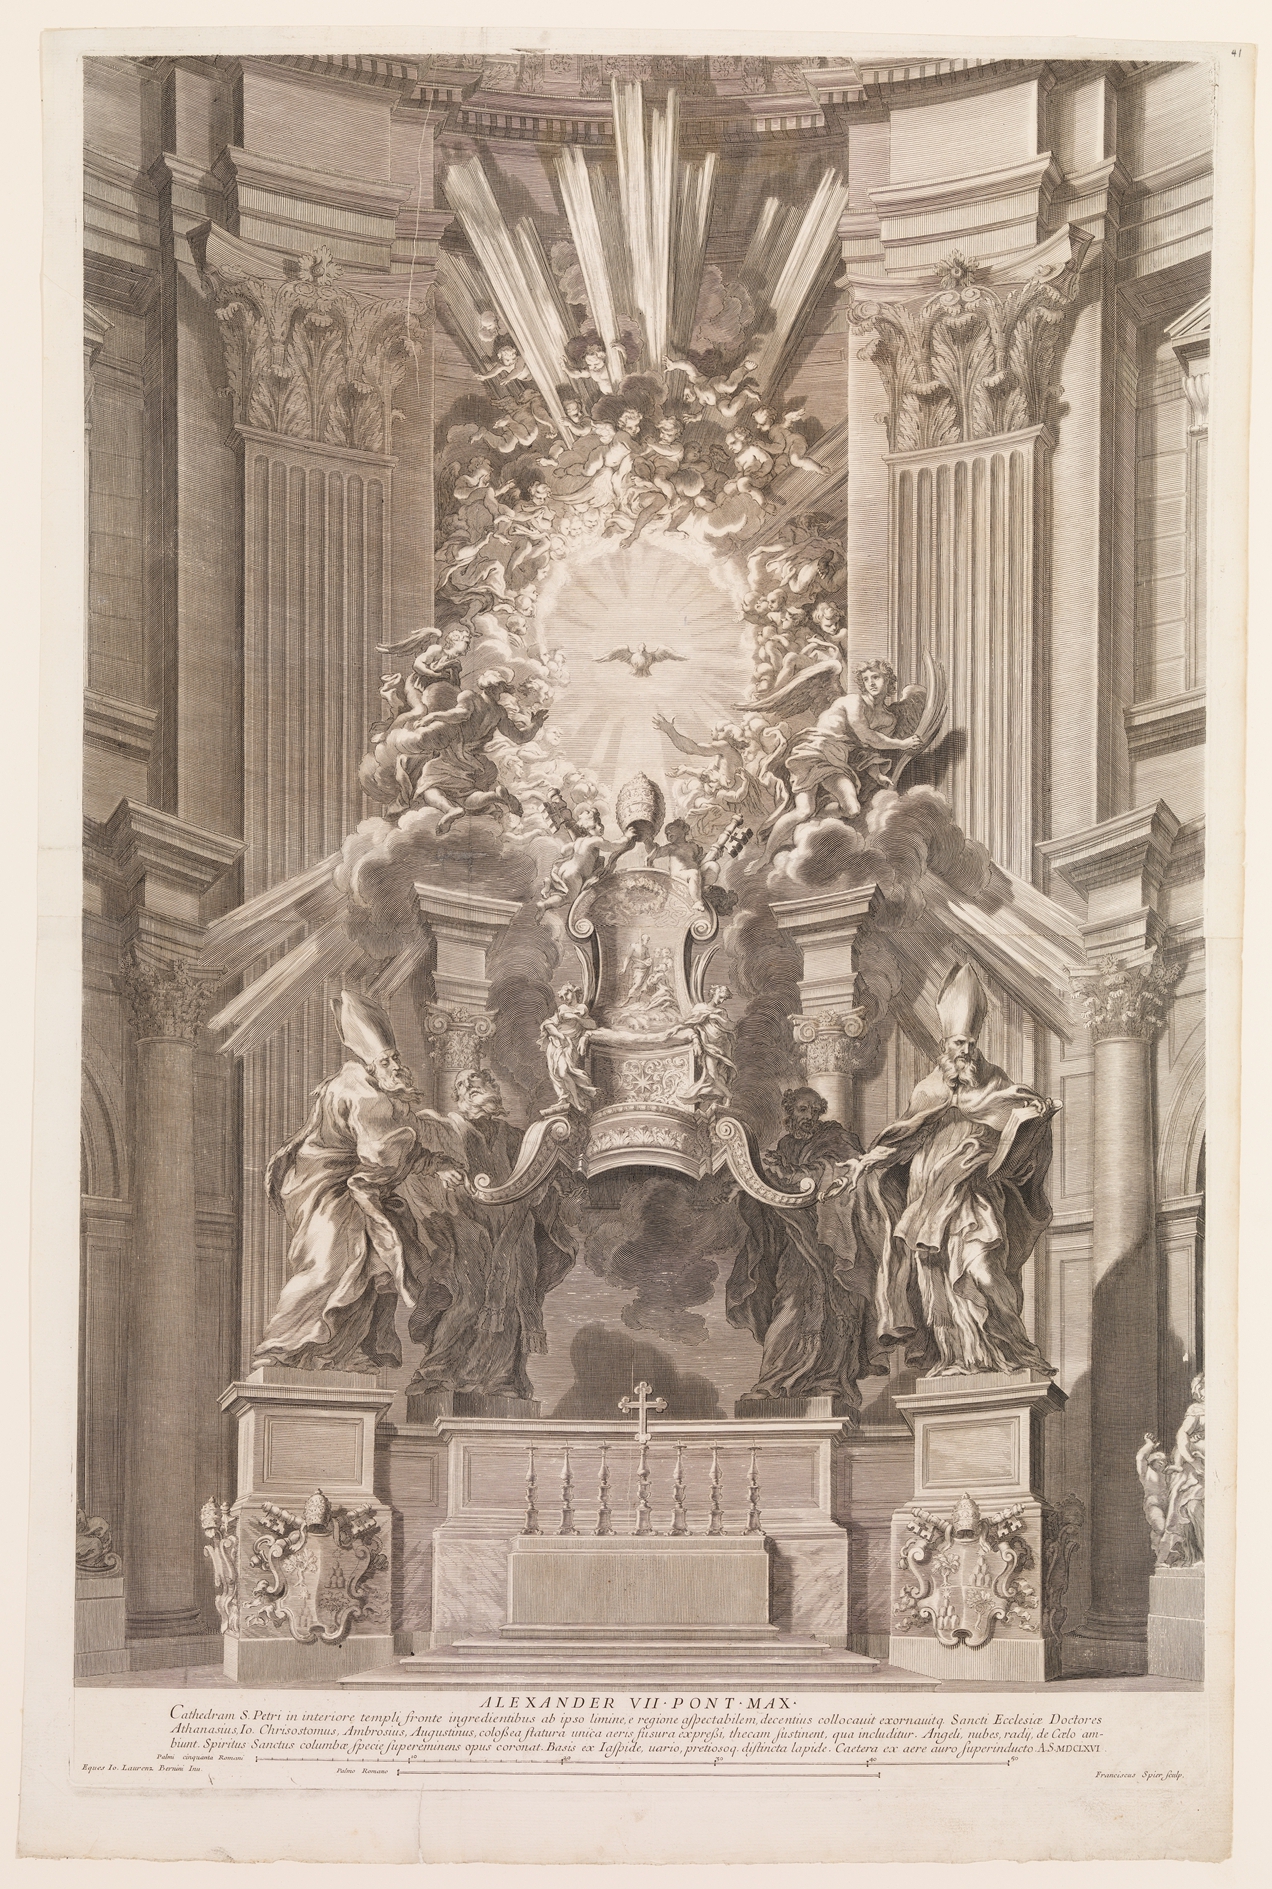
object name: collection ornament architecture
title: Cathedram S. Petri in interiore templi fronte...Plate 41 from the Album 'Basilica di S. Pietro in Vaticano'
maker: françois spierre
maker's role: artist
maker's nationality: french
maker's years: 1639-1681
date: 1666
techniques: engraving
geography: rome?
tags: interiors,churches